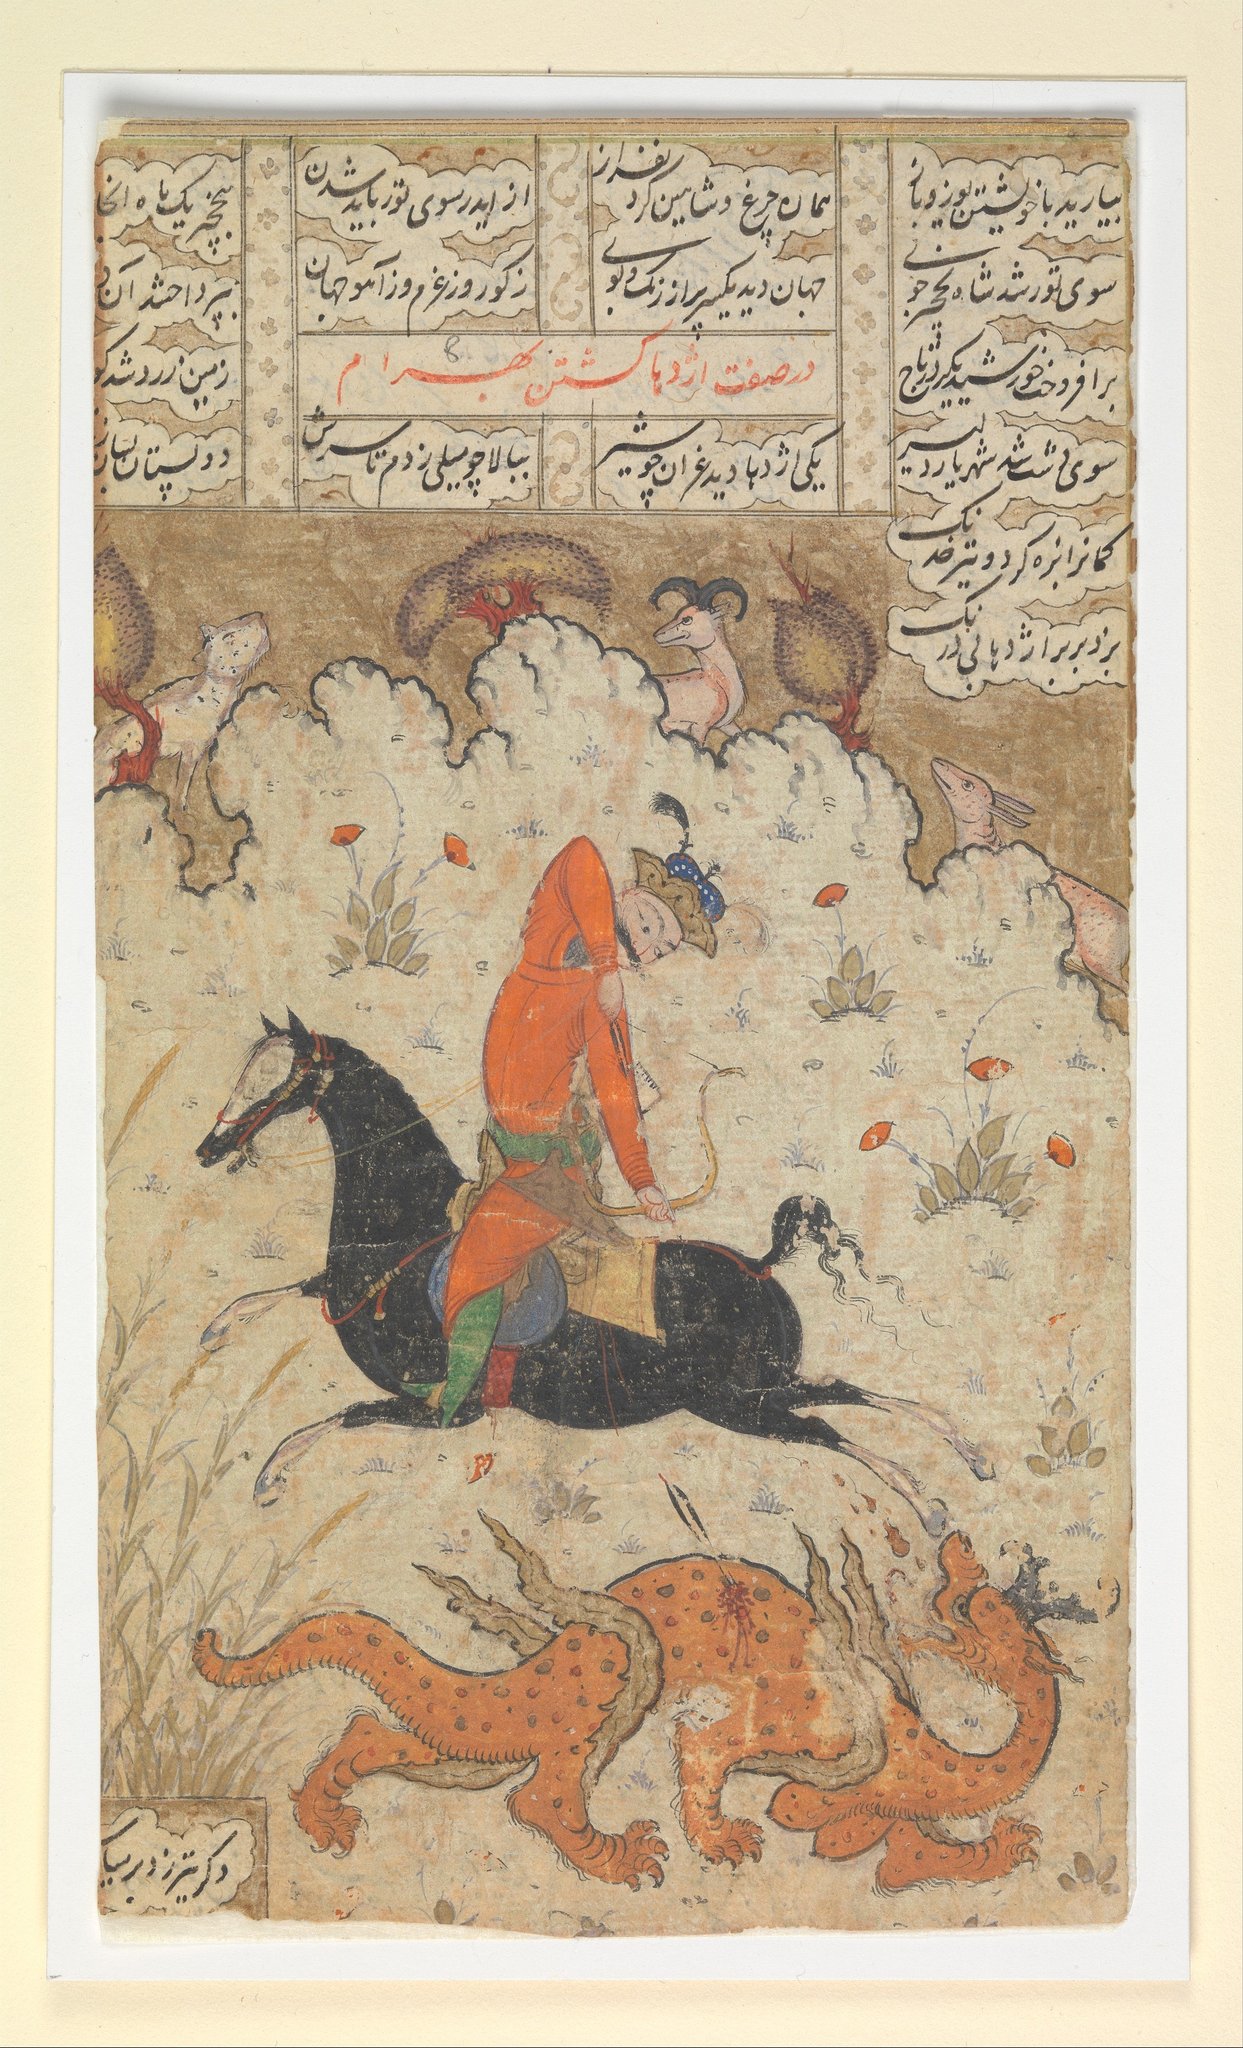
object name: folio from an illustrated manuscript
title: "Bahram Gur Slays the Dragon", Folio from a Shahnama (Book of Kings)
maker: abu'l qasim firdausi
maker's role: author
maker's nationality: iranian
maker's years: 935-1020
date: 1651-1700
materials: gold, ink, paper, watercolor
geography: iran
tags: men,hunting,dragons,horses